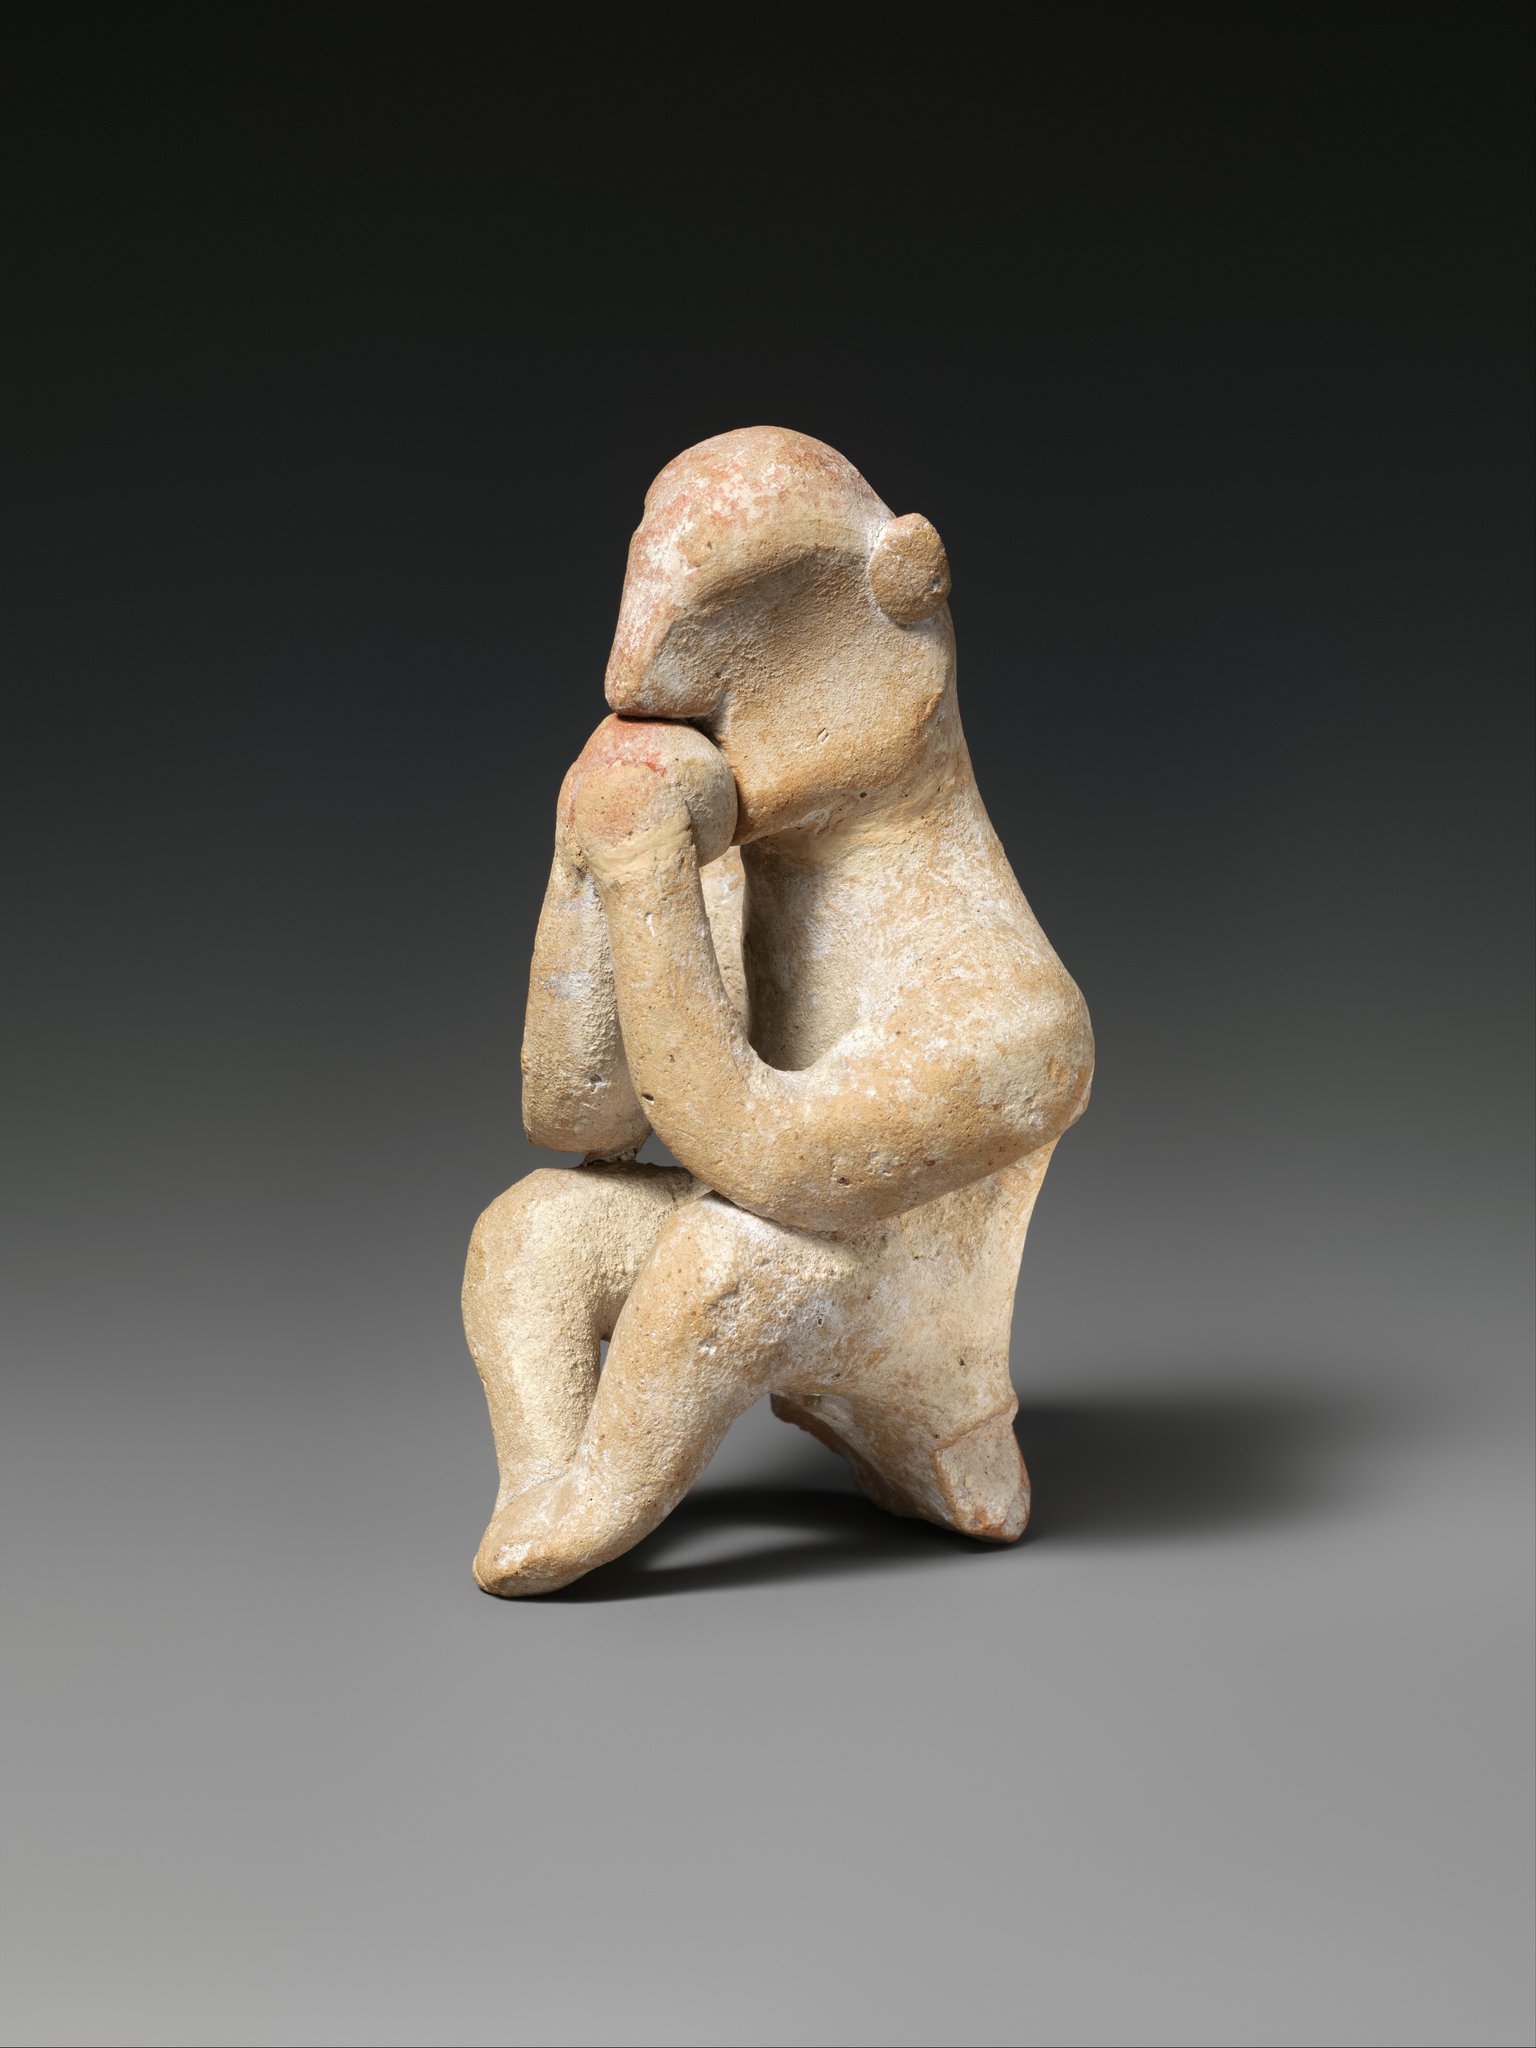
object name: male figurine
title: Terracotta figure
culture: cypriot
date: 600-480 BCE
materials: terracotta